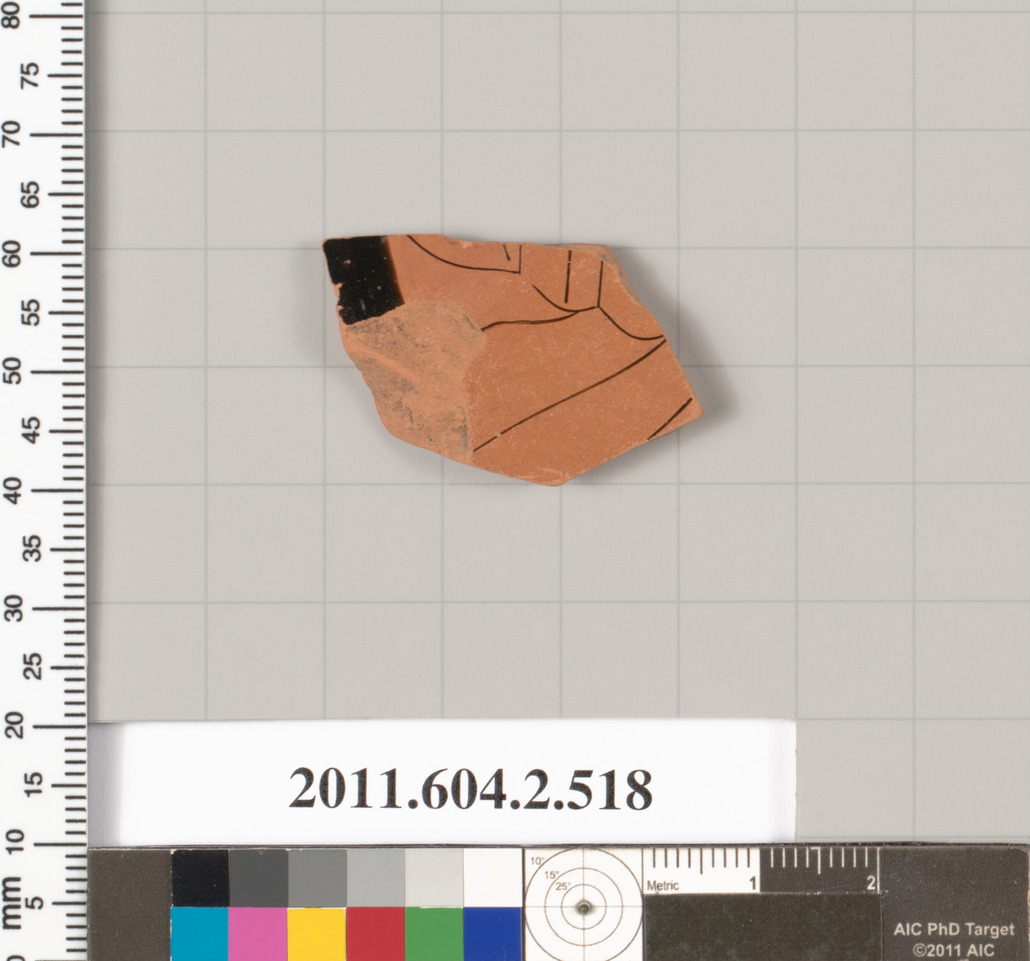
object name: column krater fragment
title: Terracotta fragment of a column-krater (bowl for mixing wine and water)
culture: greek, attic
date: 460-440 BCE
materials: terracotta